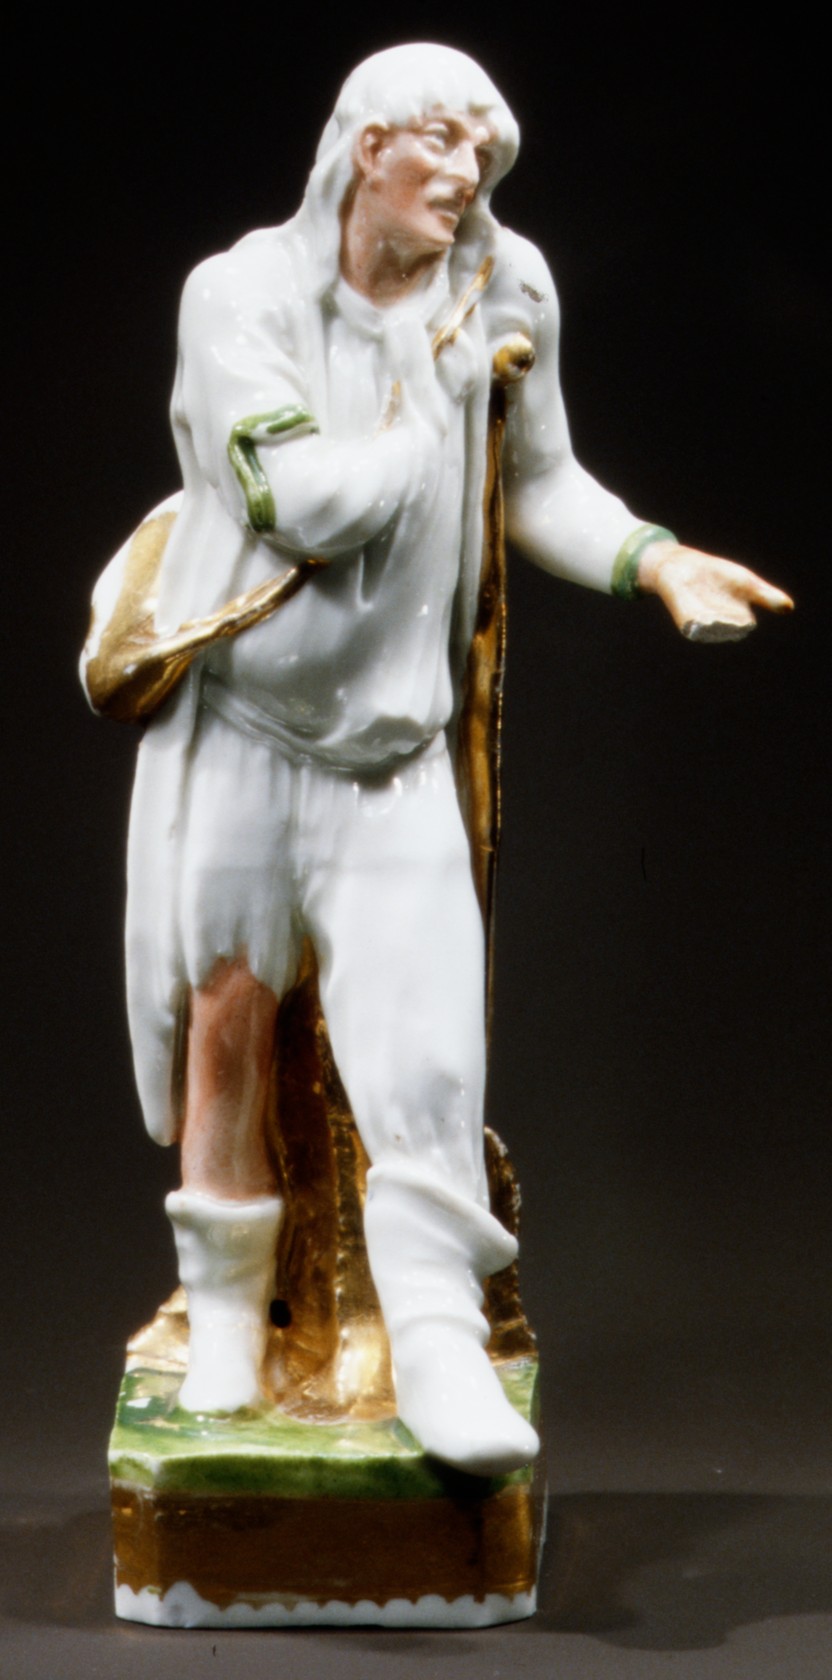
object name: figure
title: Beggar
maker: meissen manufactory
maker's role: manufactory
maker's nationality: german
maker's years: 1710-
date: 1725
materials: hard paste porcelain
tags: men